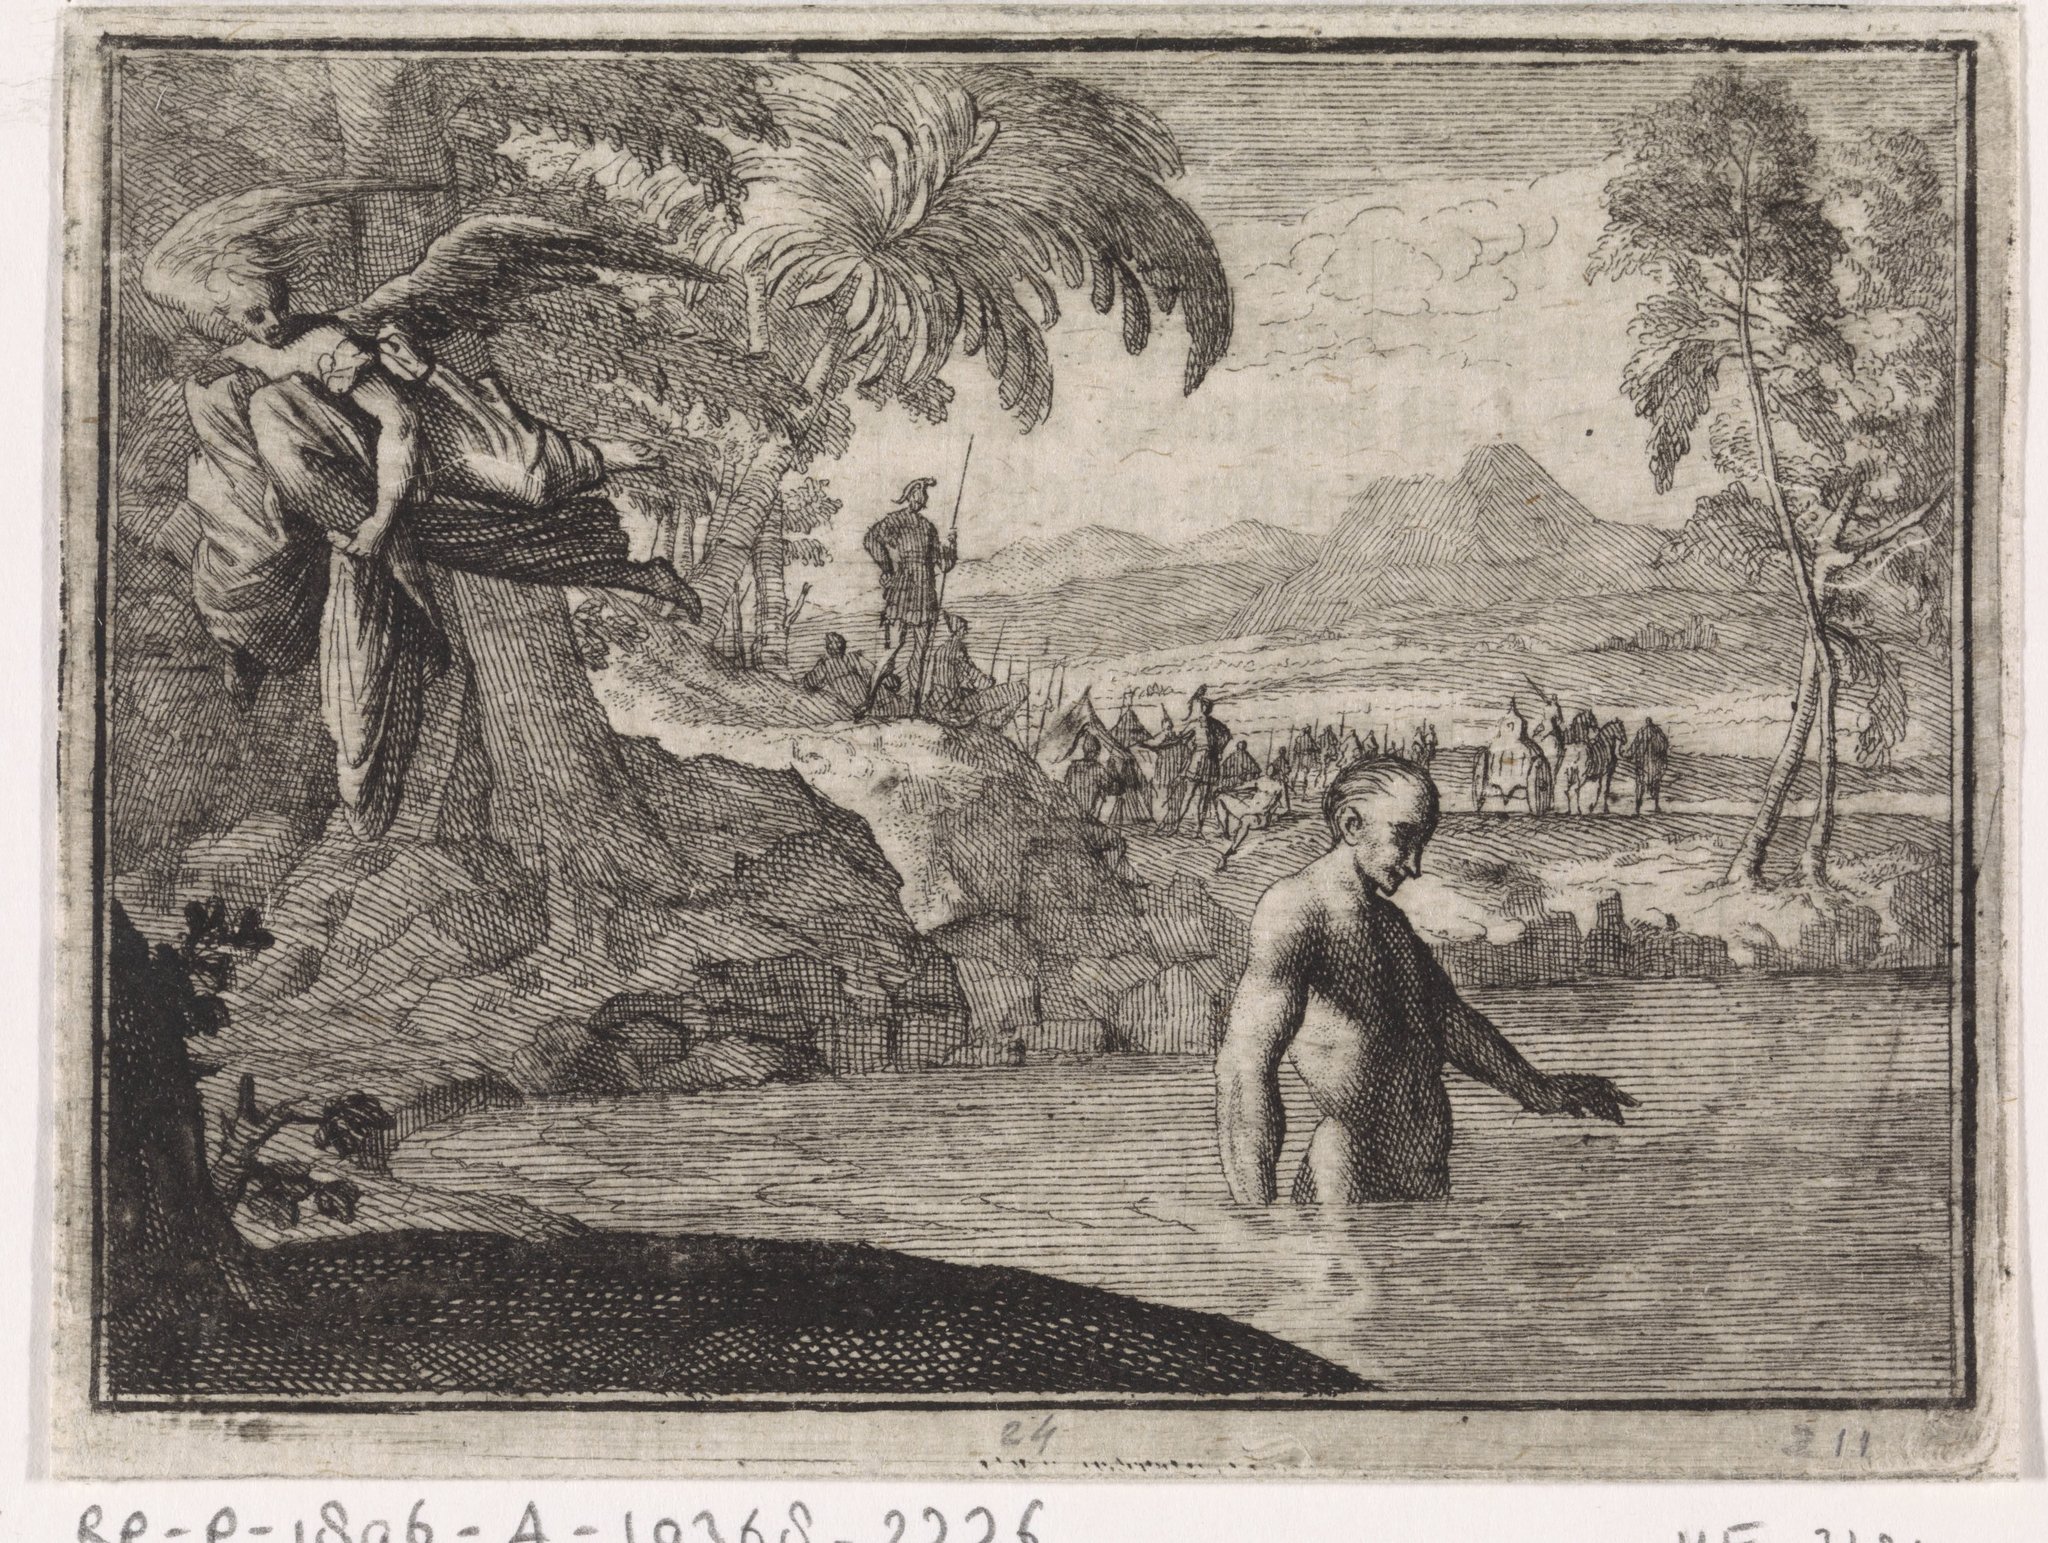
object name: print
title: Engel vliegt weg met de kleding van een badende koning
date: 1704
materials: paper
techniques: etching, letterpress printing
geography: nuremberg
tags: washing and bathing - aa - in the open air, angels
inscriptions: collector's mark: Lugt 2228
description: Illustratie uit: Abraham a Sancta Clara. Heilsames Gemisch Gemasch, das ist: Allerley seltsame und verwunderliche Geschichten (...). Neurenberg: Christoph Weigel, 1704, p. 211.